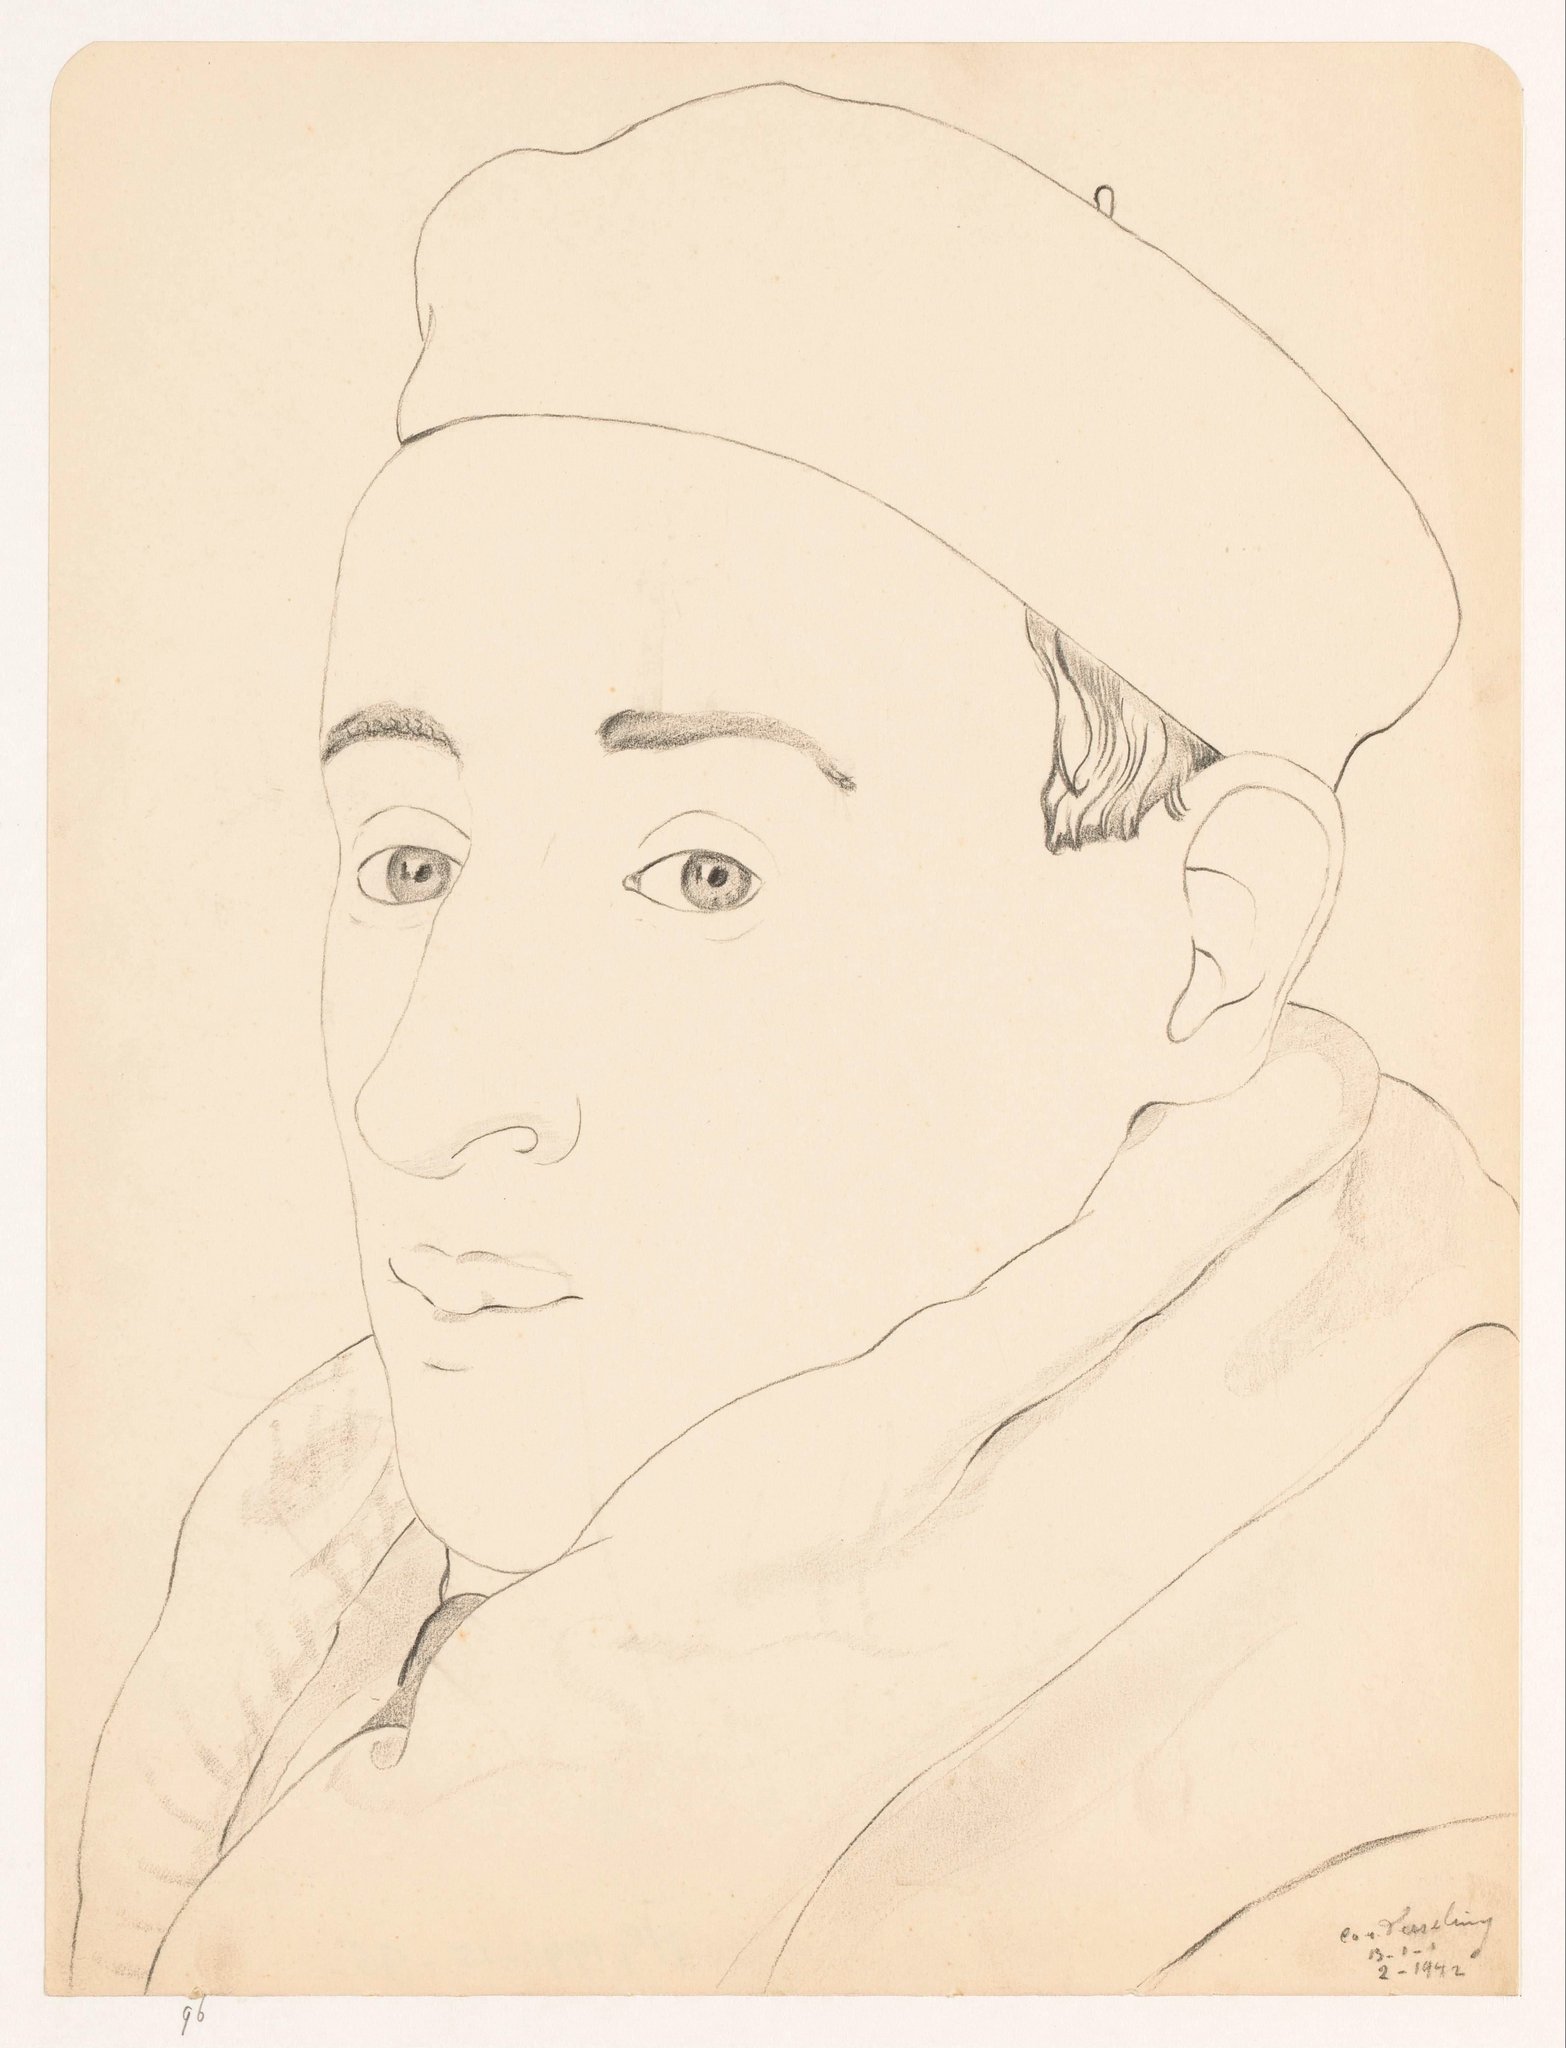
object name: drawing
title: Zelfportret met pet: B-1-1, februari 1942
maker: cor van teeseling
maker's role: draughtsman, sculptor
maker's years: 1915-1942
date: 1902-1942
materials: paper, pencil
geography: weteringschans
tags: amsterdam, draughtsman, sculptor, cor van teeseling, historical persons, prisoner in cell or locked place, portrait, self-portrait of draughtsman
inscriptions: date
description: Zelfportret van Cor van Teeseling met pet: B-1-1, februari 1942. Zelfportret van Cor van Teeseling met pet driekwart, naar links kijkend.